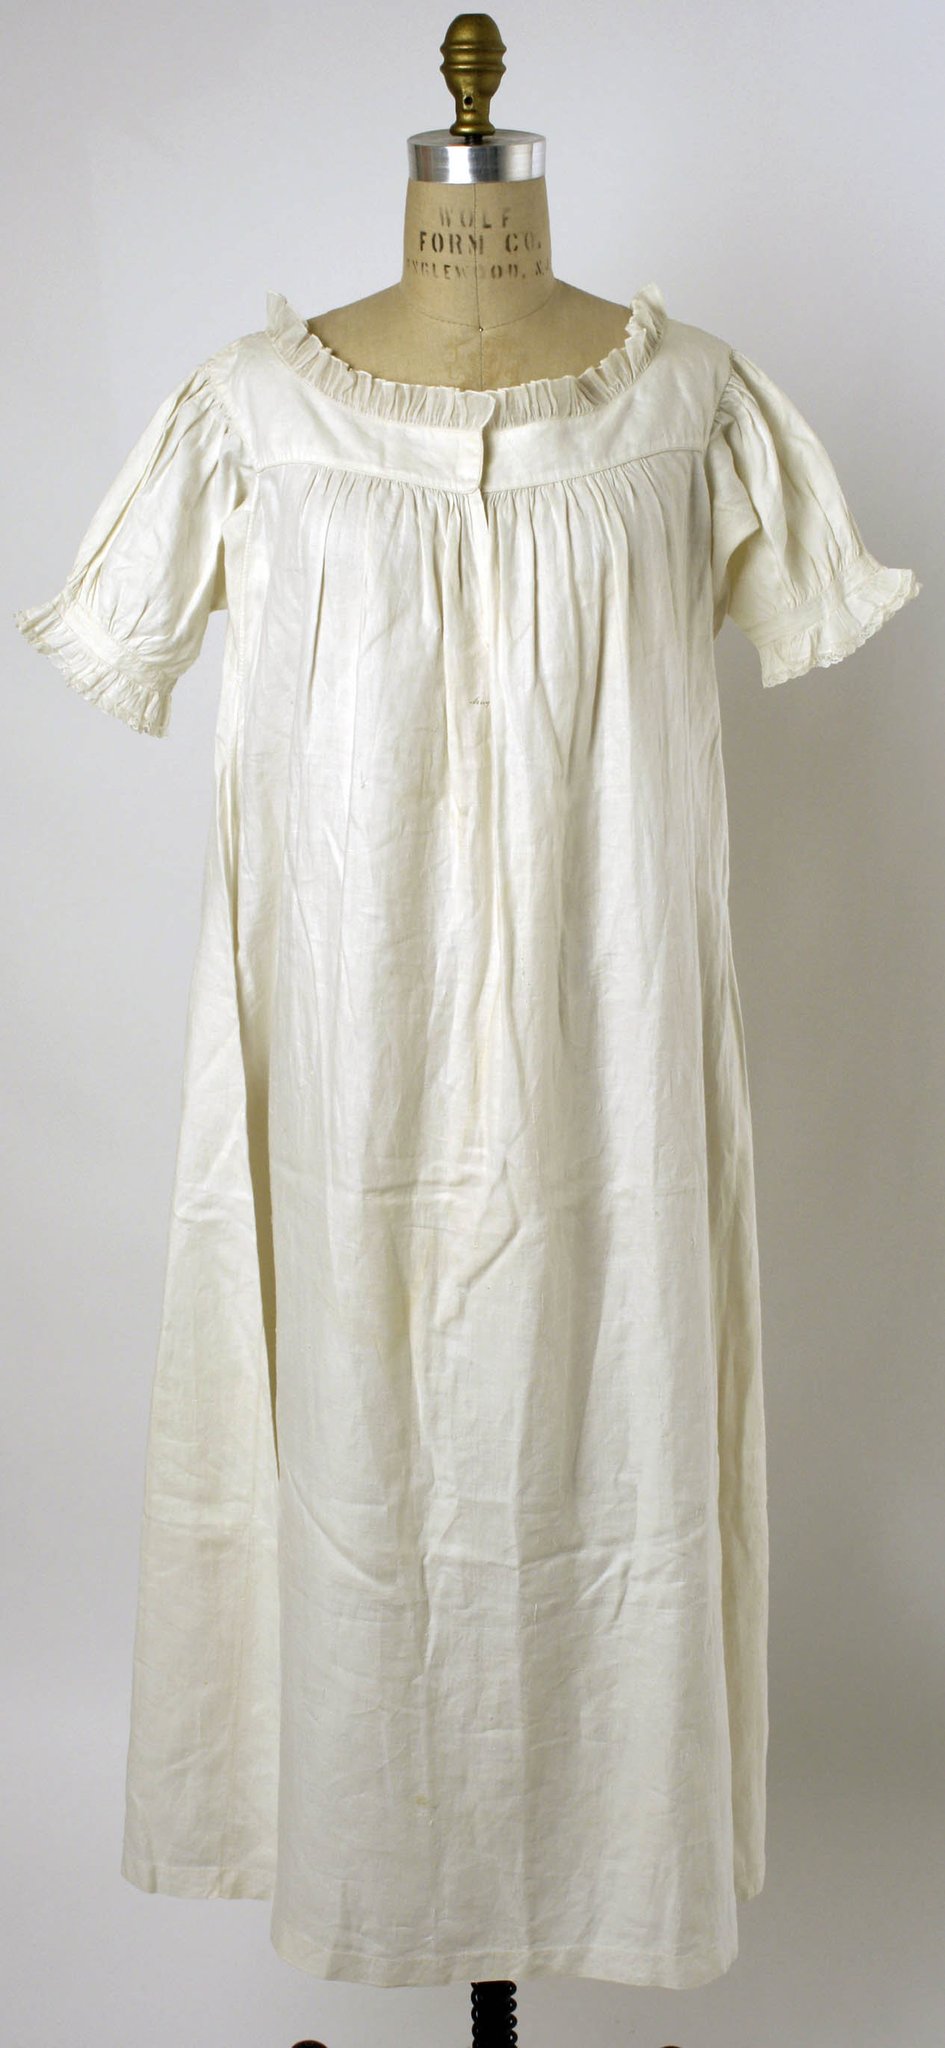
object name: chemise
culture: american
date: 1830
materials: linen